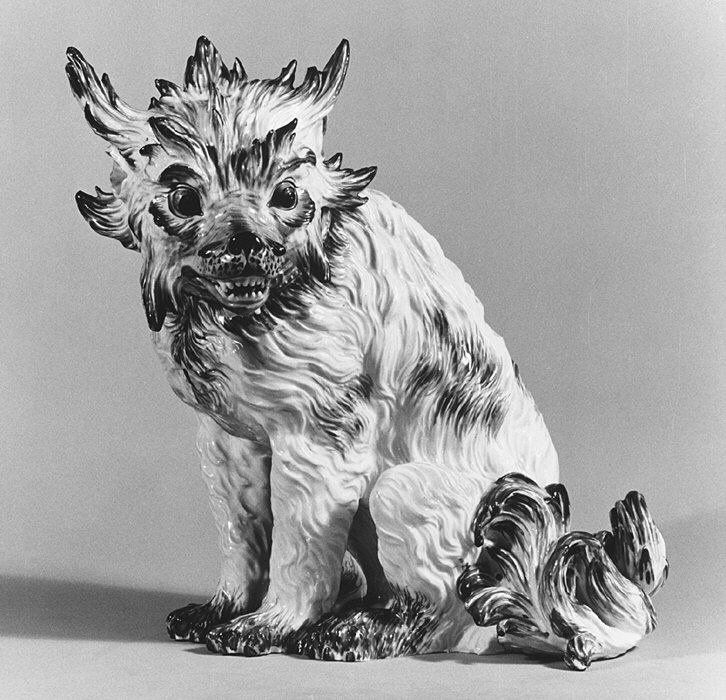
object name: figure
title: Bolognese dog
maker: meissen manufactory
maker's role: manufactory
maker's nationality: german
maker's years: 1710-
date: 1733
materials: hard paste porcelain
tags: dogs